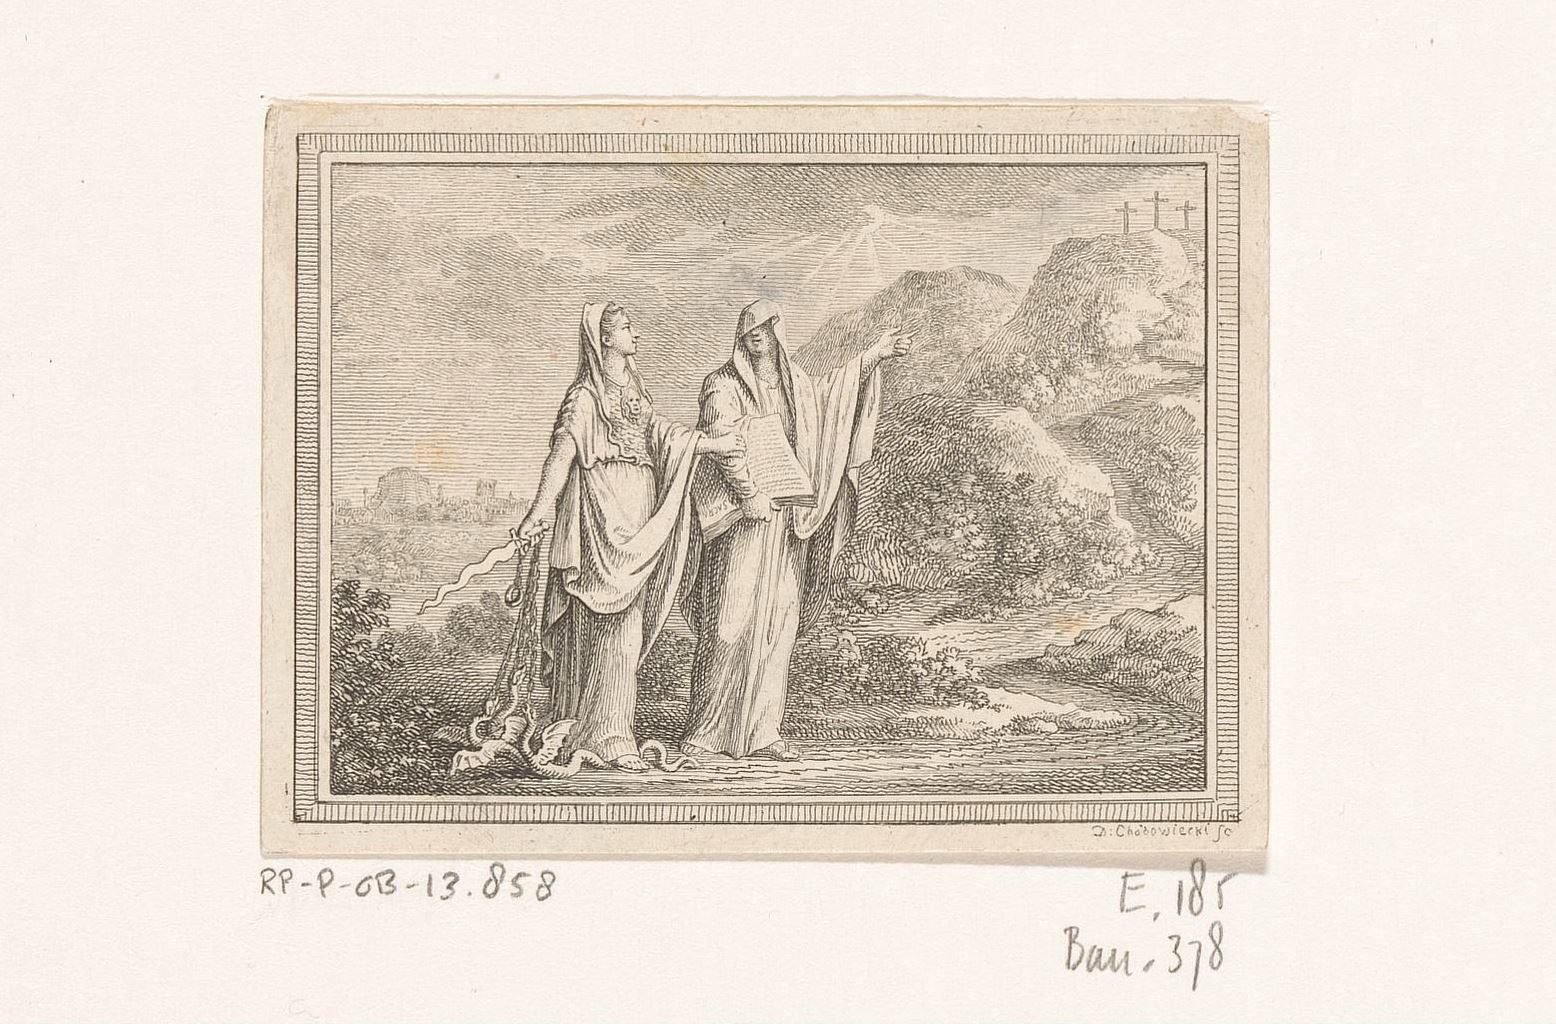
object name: print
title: Openbaring en Rede voor Golgotha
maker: daniel nikolaus chodowiecki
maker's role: draughtsman, print maker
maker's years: 1726-1801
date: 1777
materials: paper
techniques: etching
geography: berlin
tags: the cross(es) in the background, reason; 'ragione' (ripa)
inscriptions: collector's mark: Lugt 2228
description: Op de voorgrond staat Openbaring, een half gesluierde vrouw met een opengeslagen onder haar arm. Naast haar staat de Rede, een vrouw met in haar rechterhand een zwaard, staand op een slang die ze aan een ketting vasthoudt. Openbaring wijst Rede op een pad dat naar de berg Golgotha leidt.